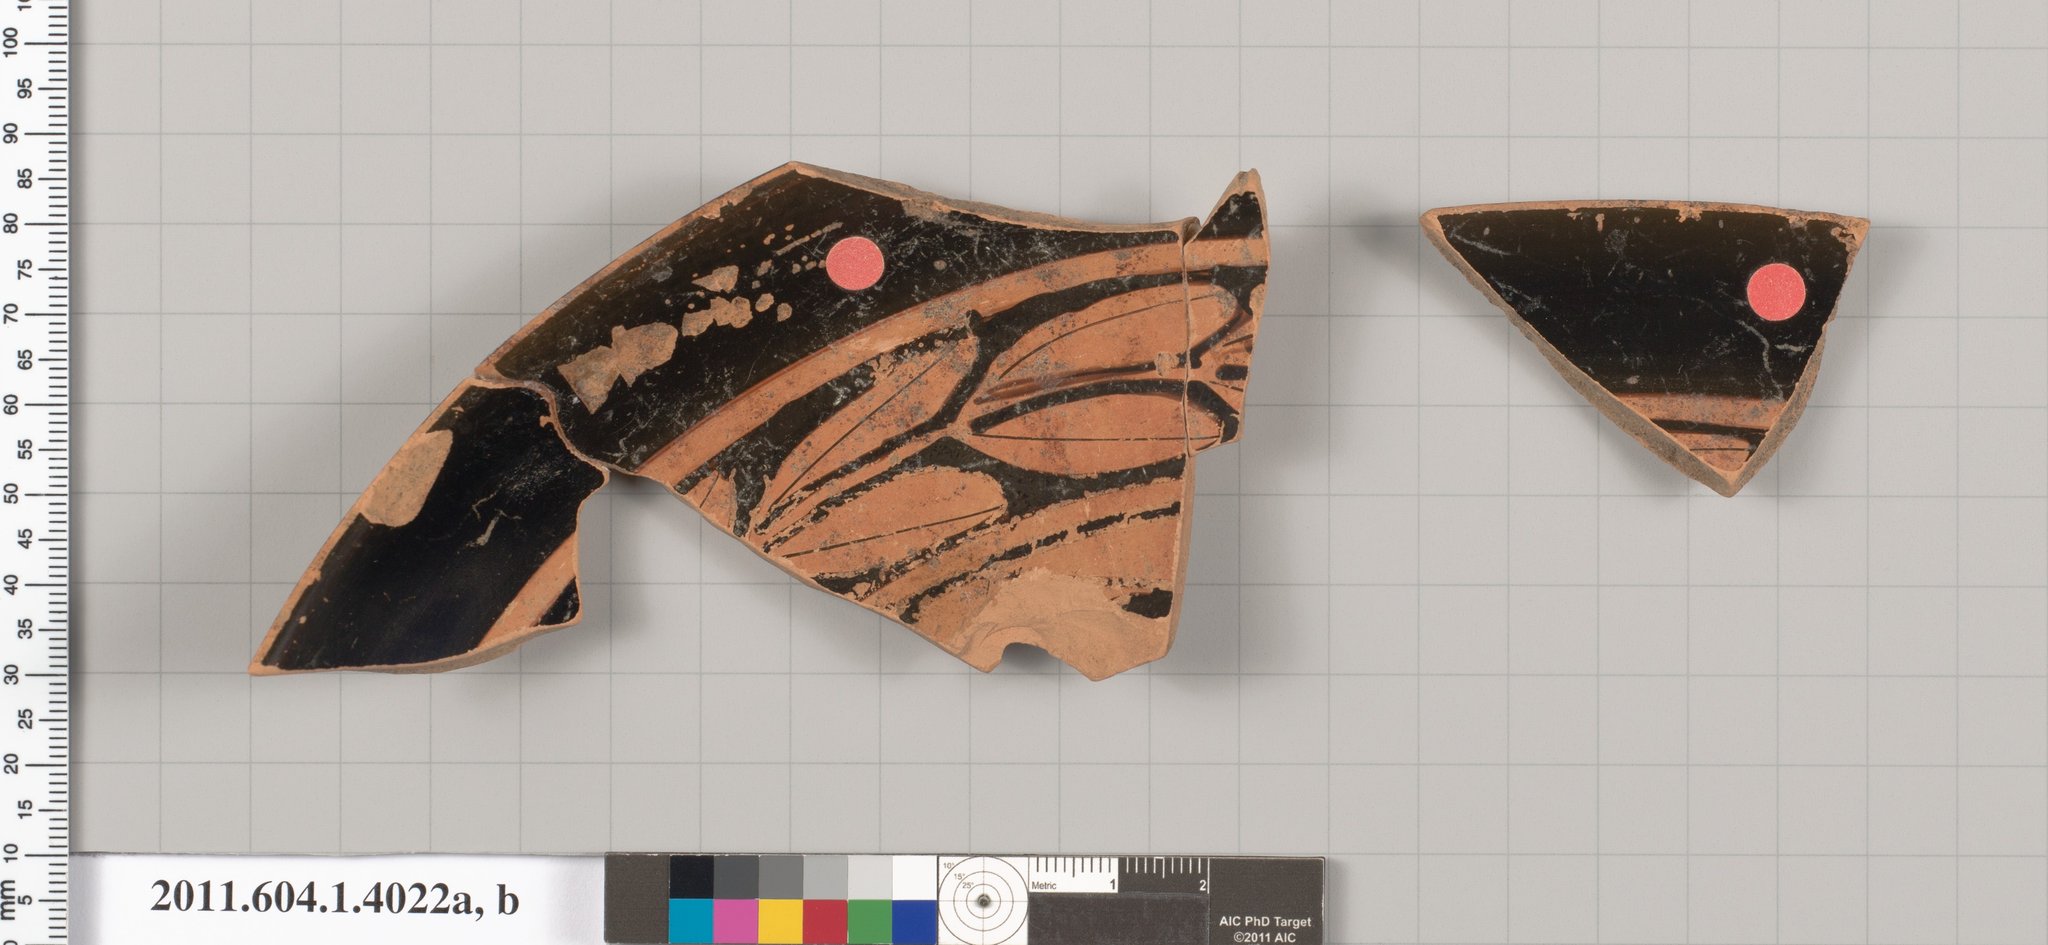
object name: kylix fragment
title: Terracotta rim fragments of a kylix (drinking cup)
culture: greek, attic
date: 460-440 BCE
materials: terracotta